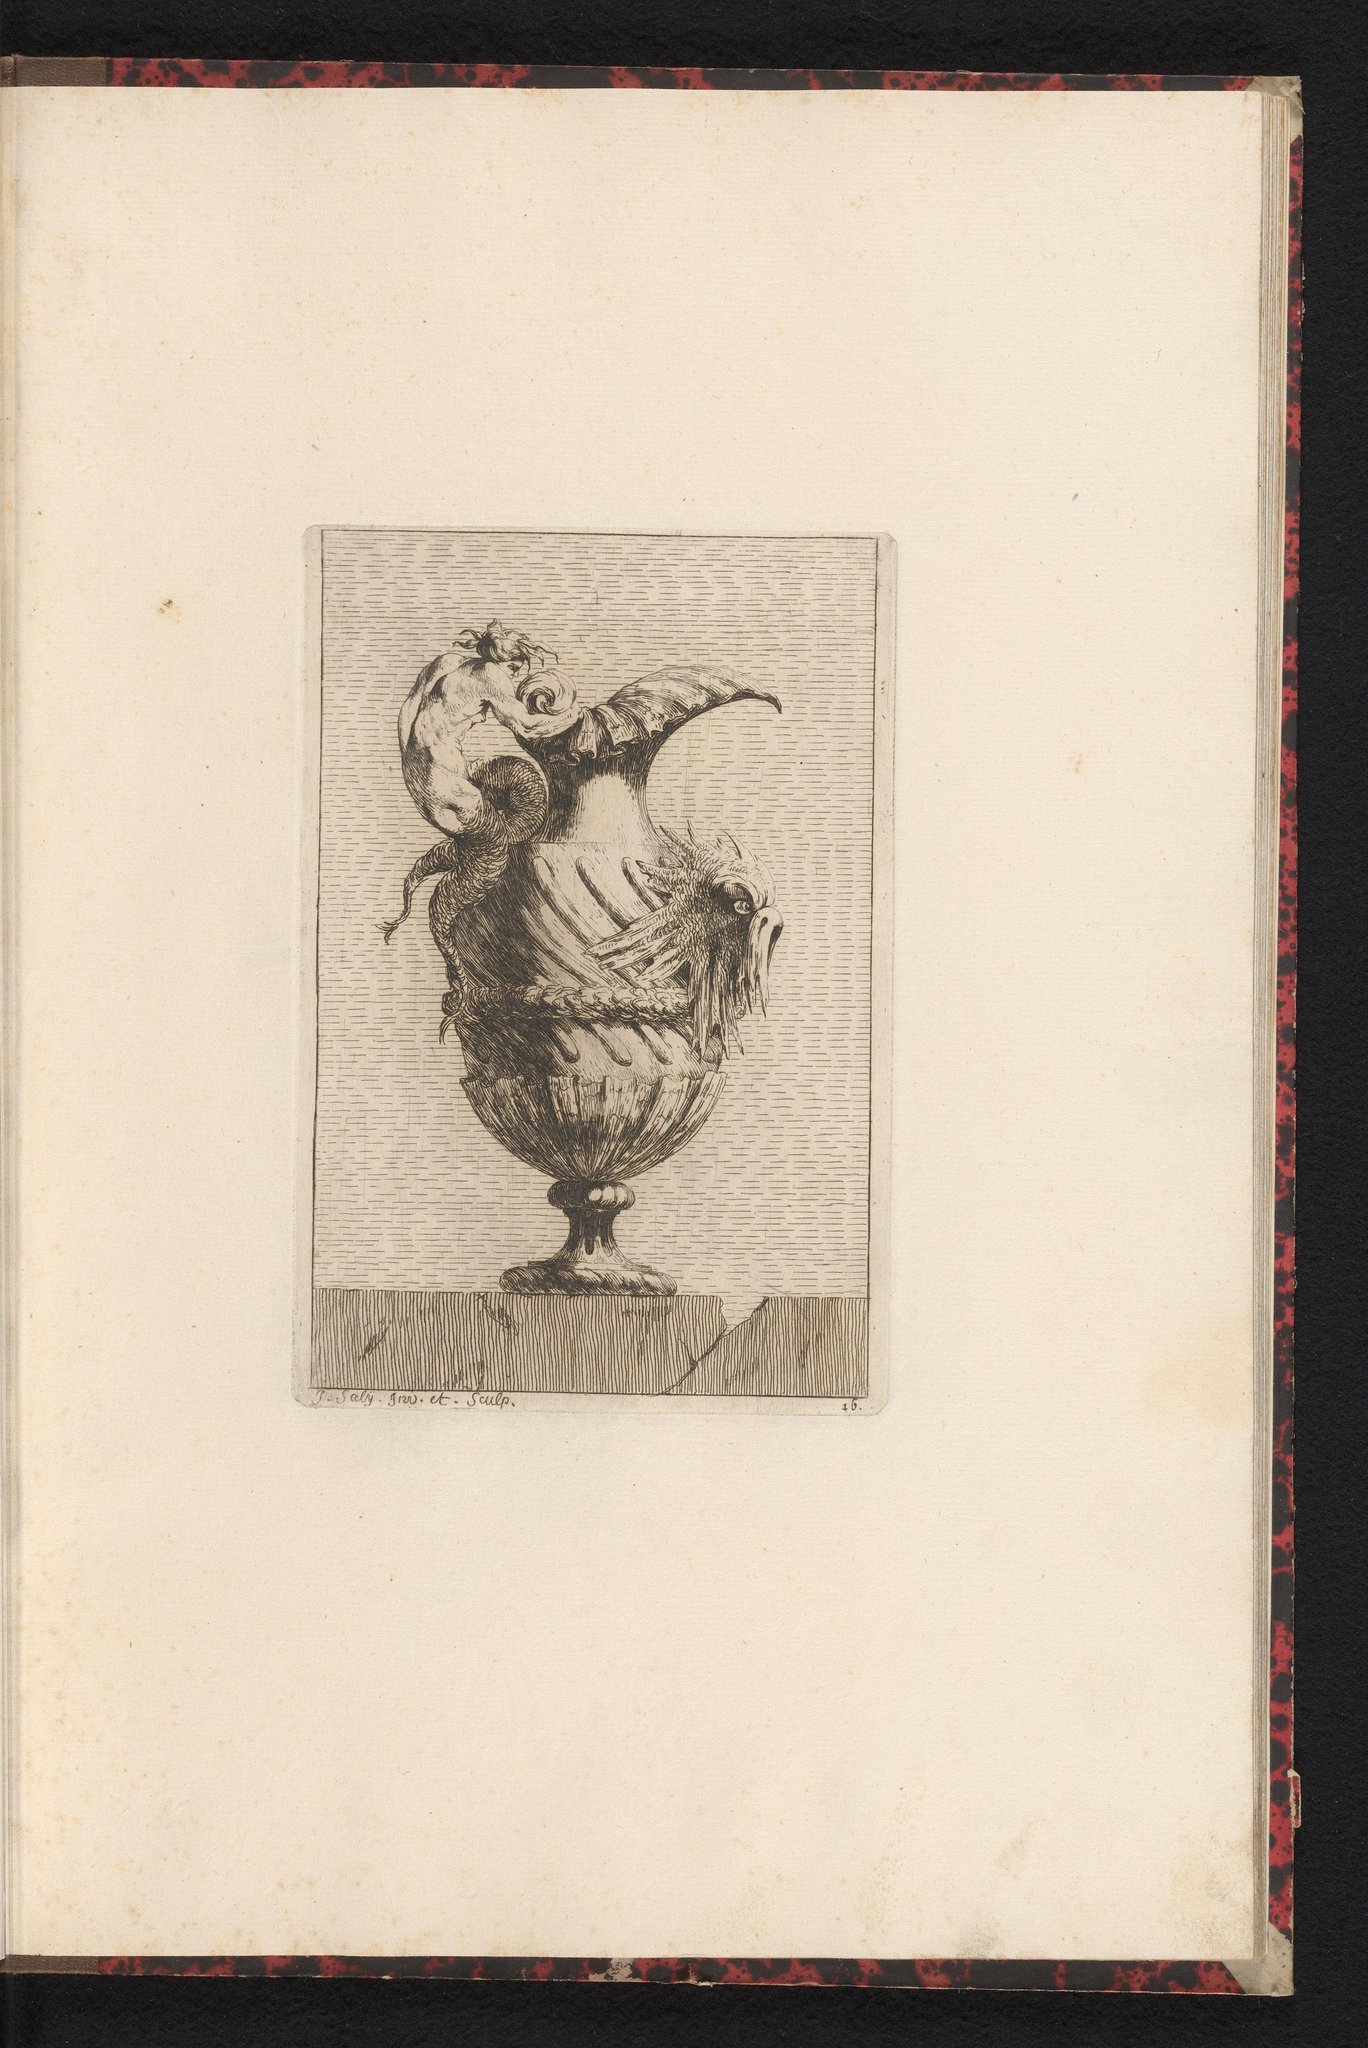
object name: album leaf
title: Ontwerpen voor vazen door Jacques Saly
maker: jacques francois joseph saly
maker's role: print maker, sculptor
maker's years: 1717-1776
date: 1746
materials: paper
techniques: etching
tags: merman - aa - mermaid, siren, mask, mascaron ~ ornament, garden vase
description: Deze prent maakt deel uit van een album.